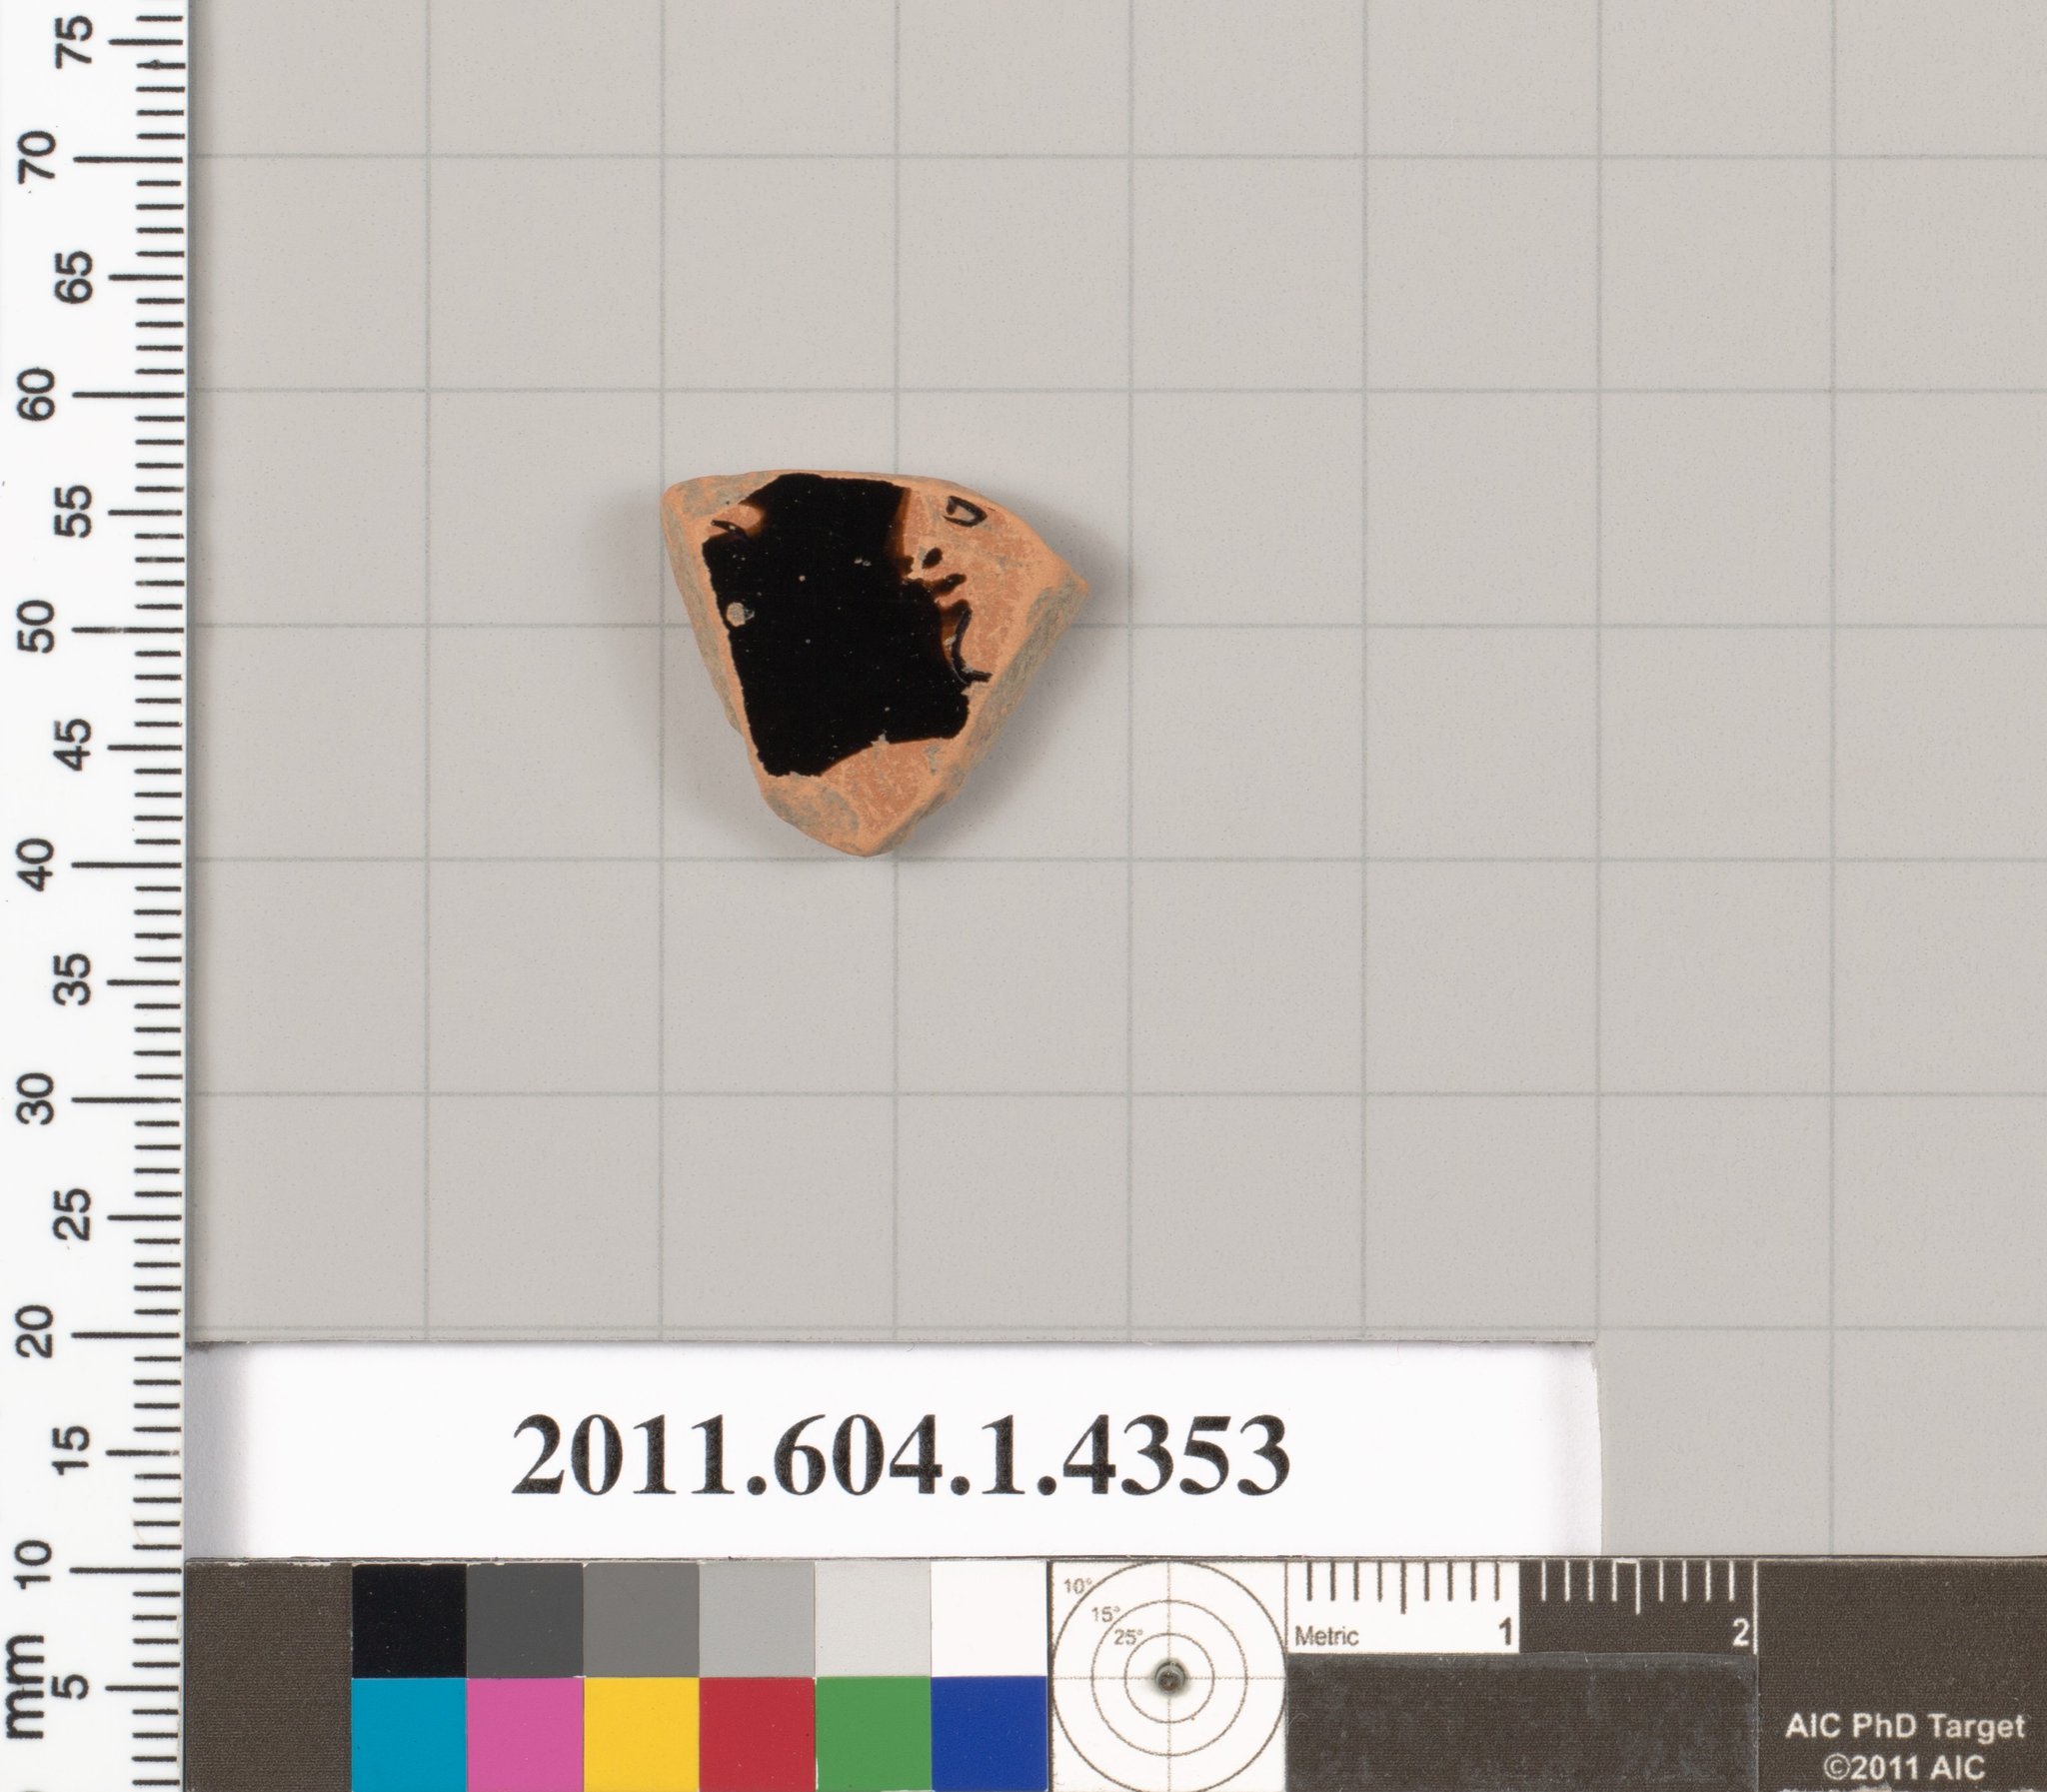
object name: kylix fragment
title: Terracotta fragment of a kylix (drinking cup)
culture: greek, attic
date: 475-451 BCE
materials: terracotta